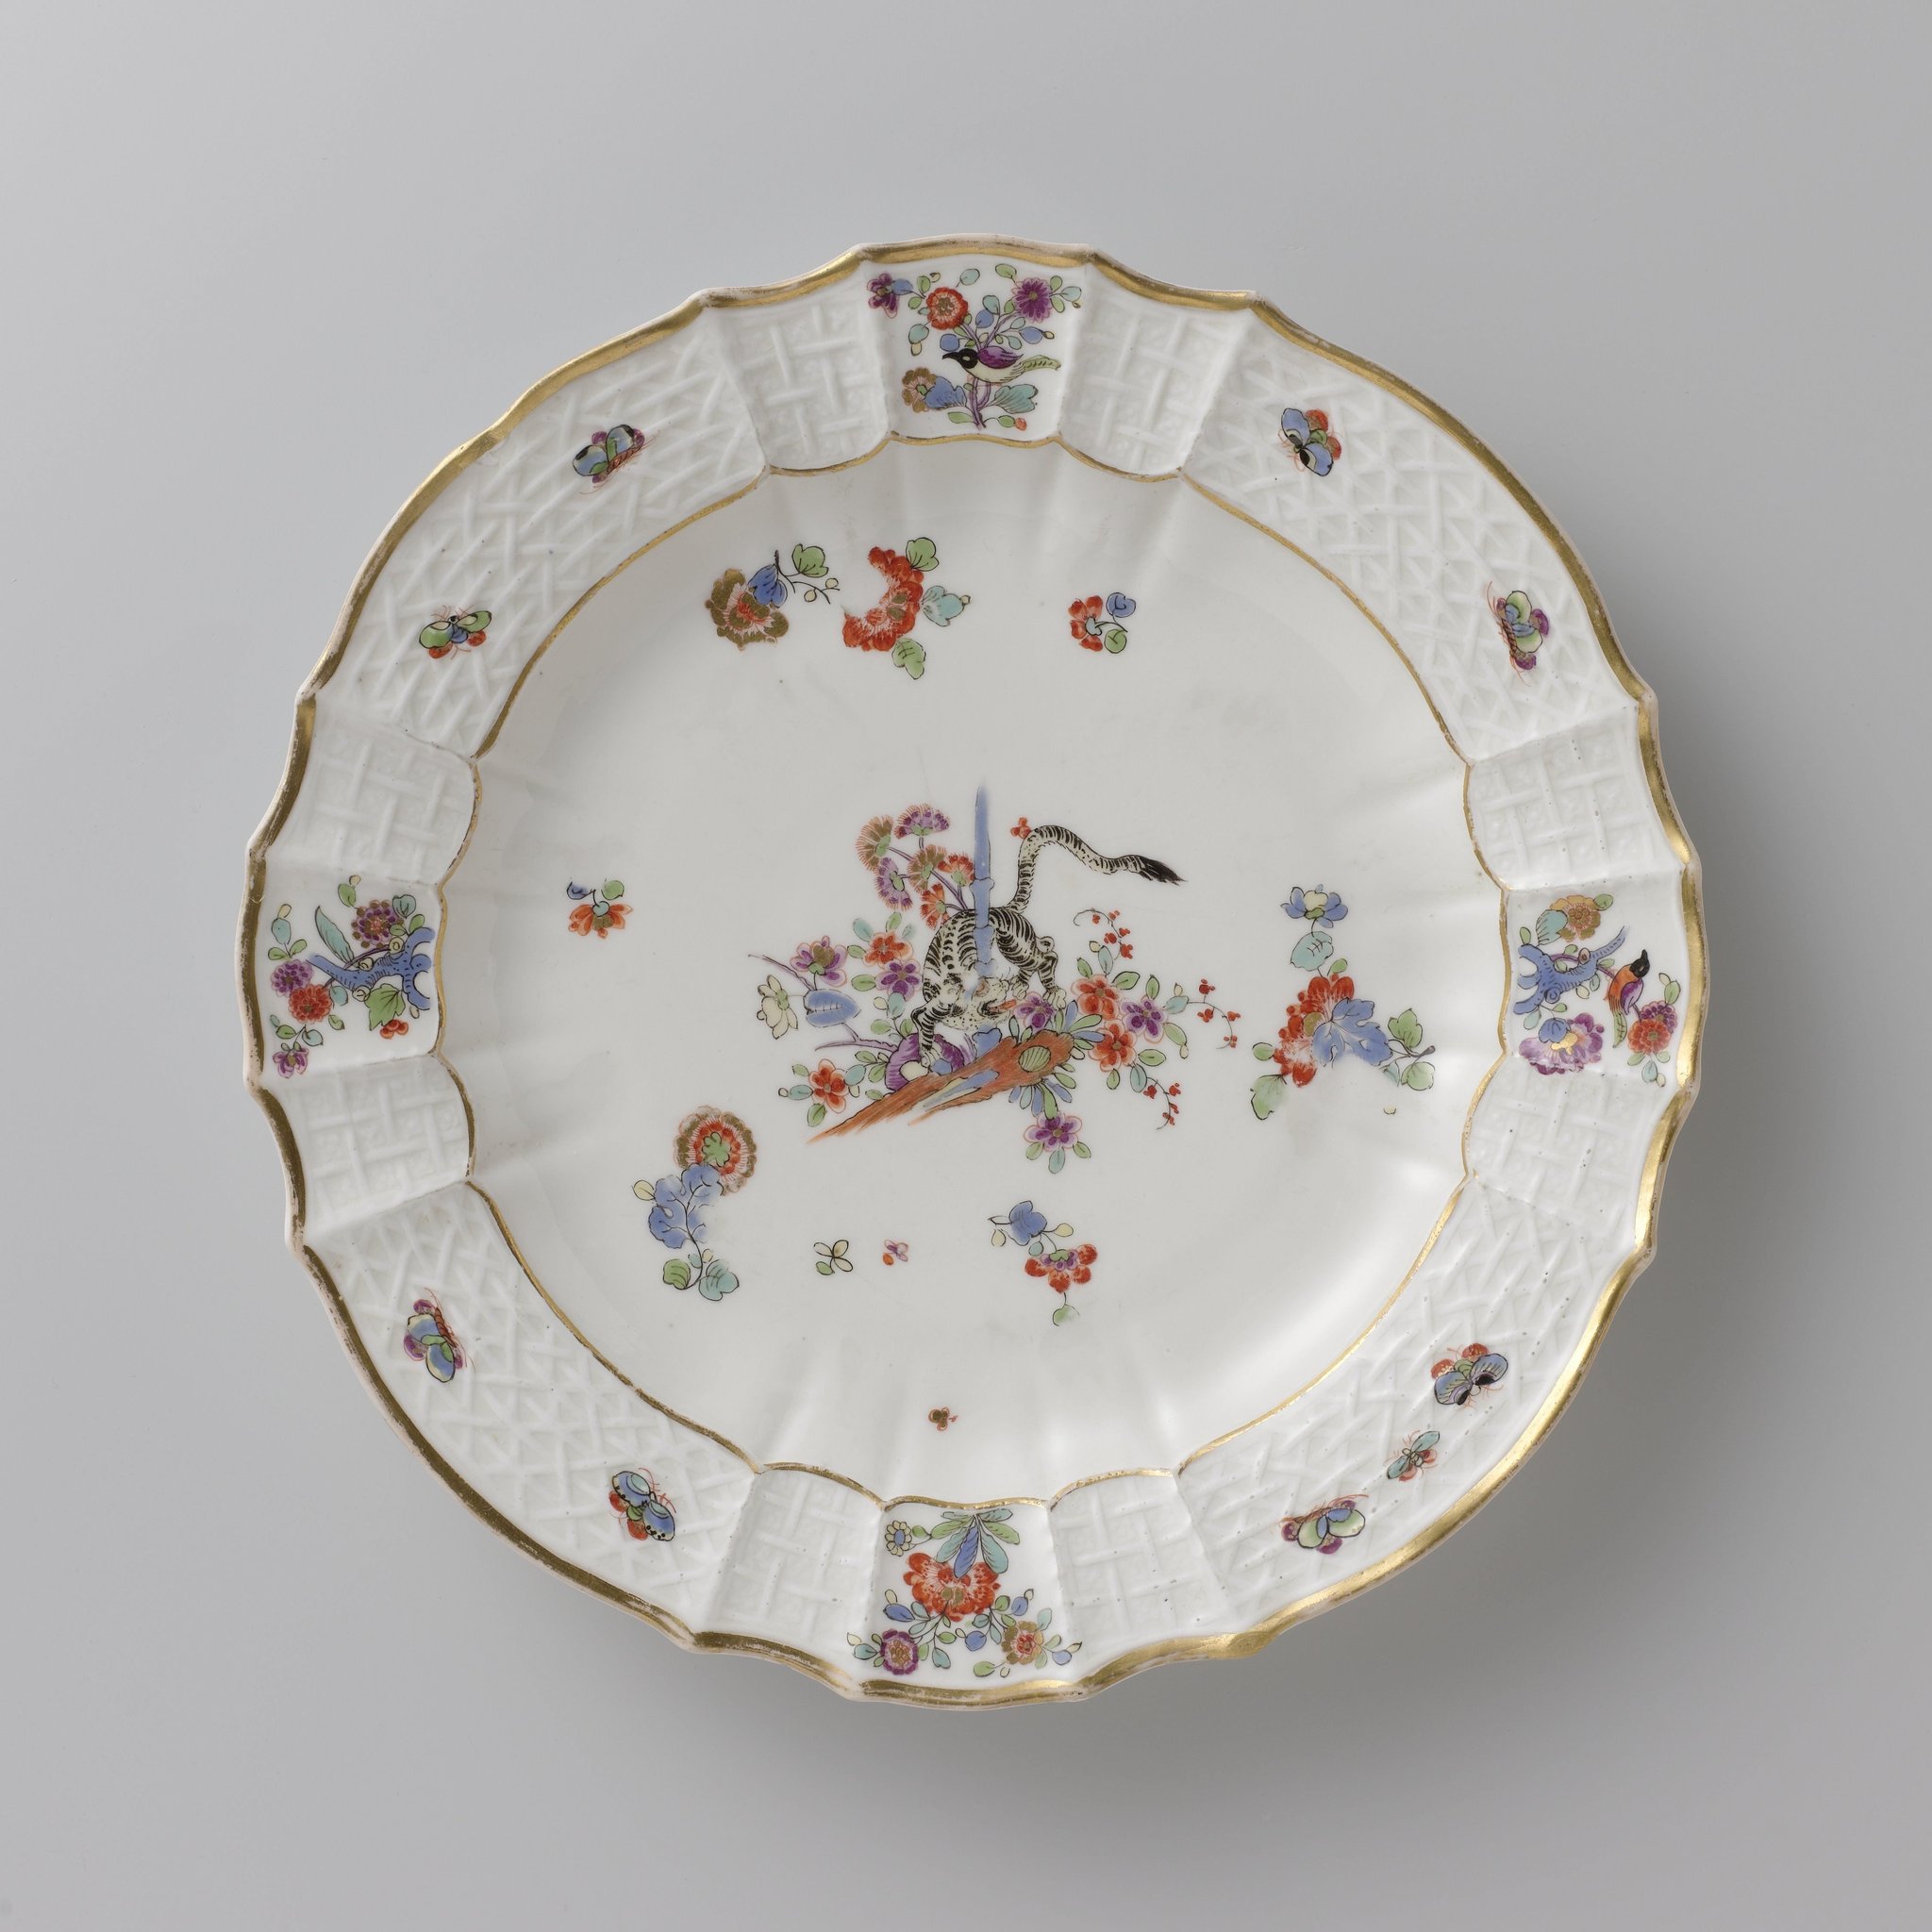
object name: eating drinking utensil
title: Rond bord, veelkleurig beschilderd met een Kakiemon-decor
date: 1740-1745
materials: porcelain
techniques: painted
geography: meissen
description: Rond bord van beschilderd porselein. Het bord is geribd en heeft een geschulpte rand. Het bord is beschilderd met een tijger die om een blauwe bamboestengel tussen bloemen is gedraaid, gestrooide Indianische Blumen, vlinders en takken waarop vogels. De rand is versierd met het 'Altbrandenstein'-patroon. Het bord is gemerkt.